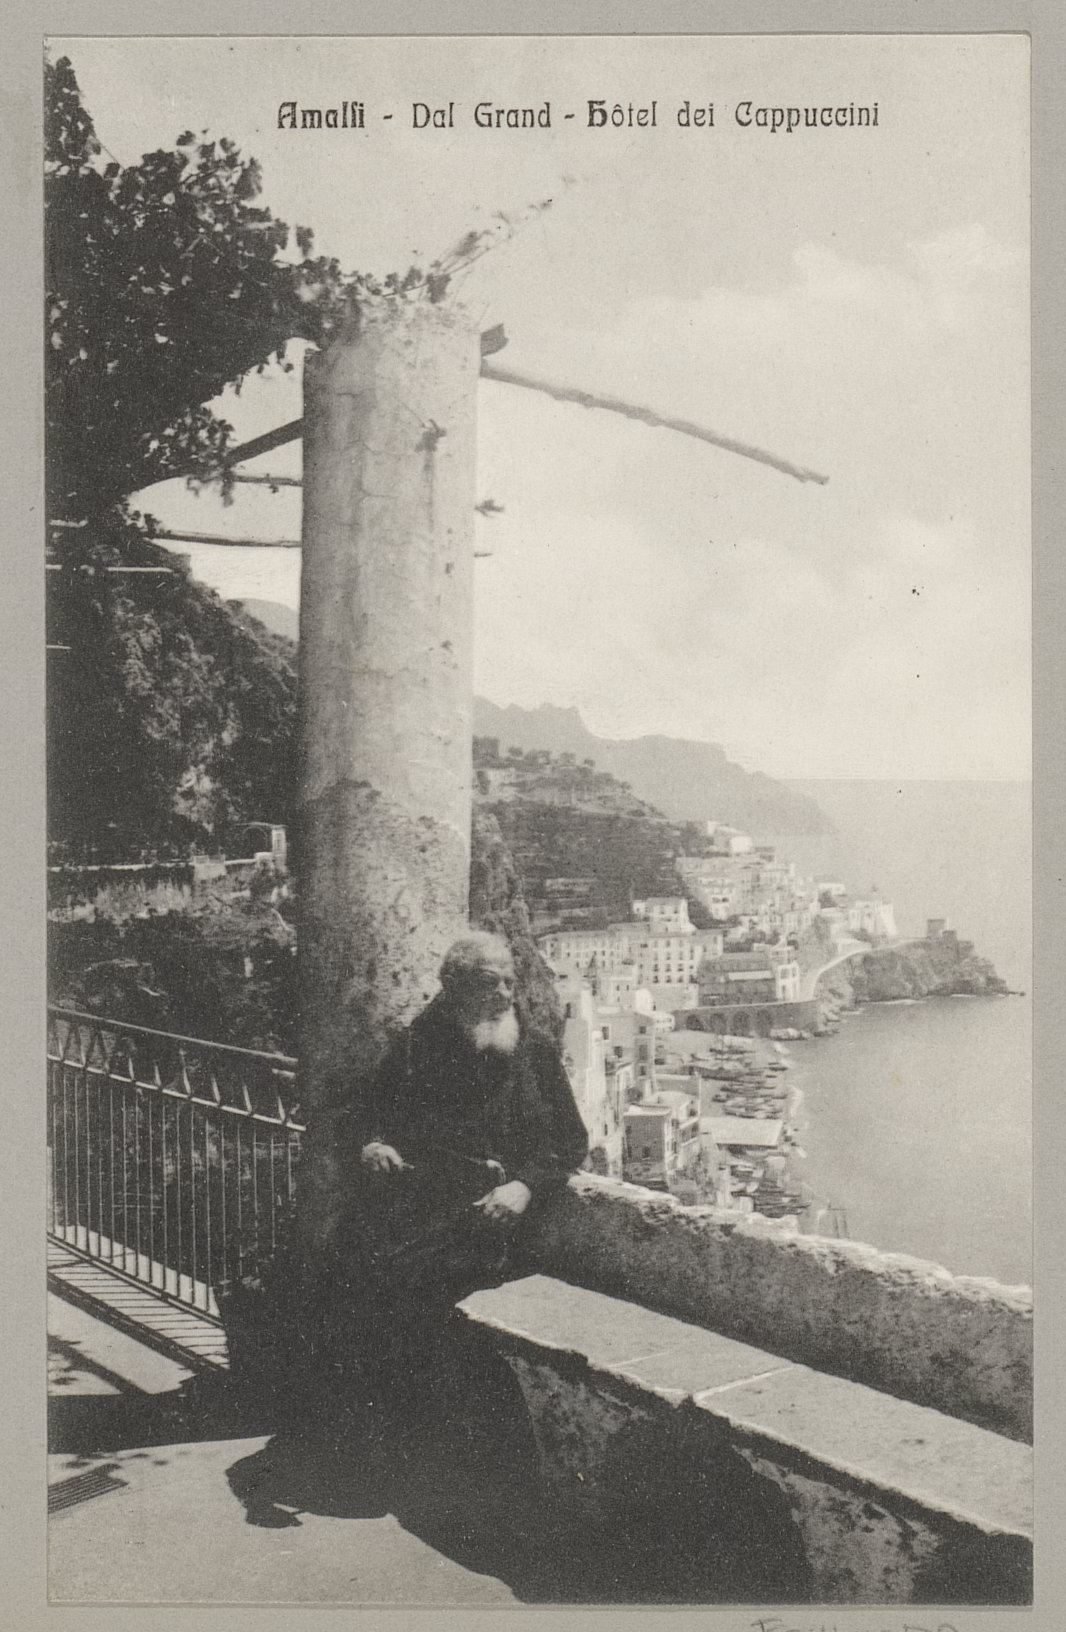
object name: ansichtkaart, prentbriefkaart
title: Gezicht op Amalfi vanuit Grand Hotel dei Cappuccini, op de voorgrond een kapucijnermonnik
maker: Anonymous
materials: paper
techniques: photograph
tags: prospect of village, silhouette of village, monk(s), friar(s), amalfi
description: Onderdeel van Fotoalbum van een reis door Zuid-Europa en het Midden-Oosten.